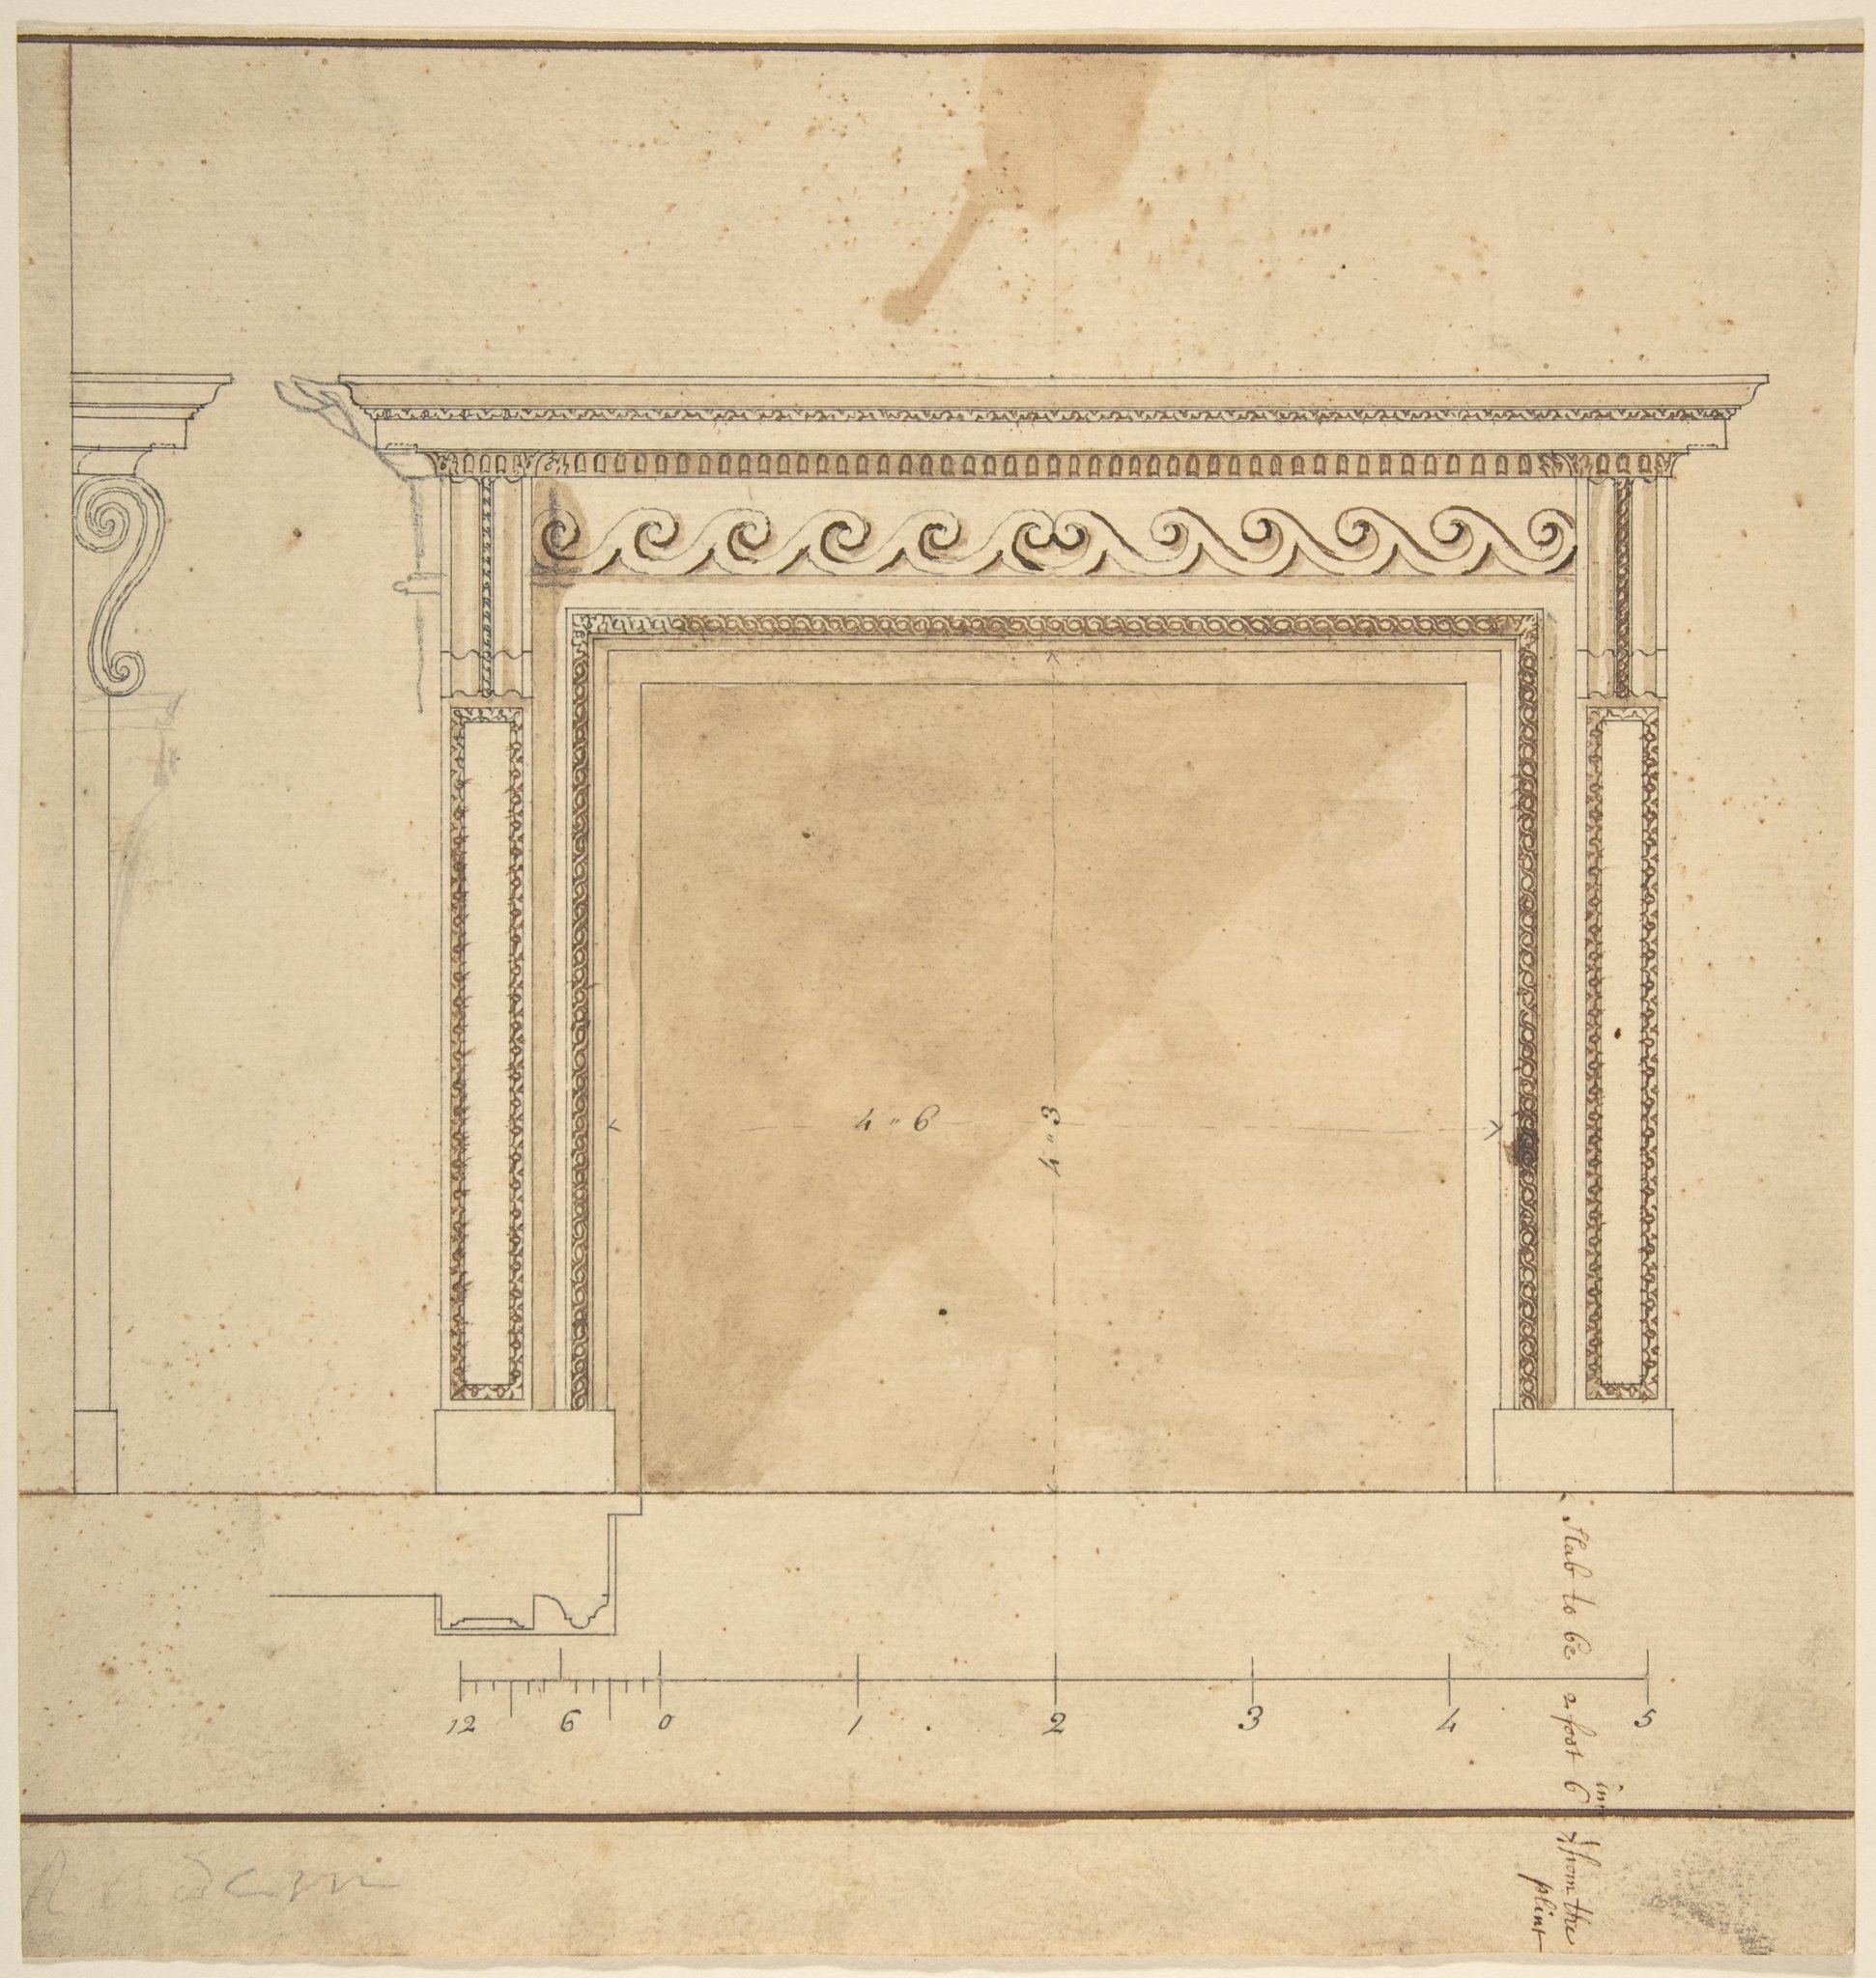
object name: drawing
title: Design for a Chimneypiece with Scalloped Moldings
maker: sir william chambers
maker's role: artist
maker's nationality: british, born sweden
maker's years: 1723-1796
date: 1743-1796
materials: graphite, ink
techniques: brush, pen, wash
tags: architecture